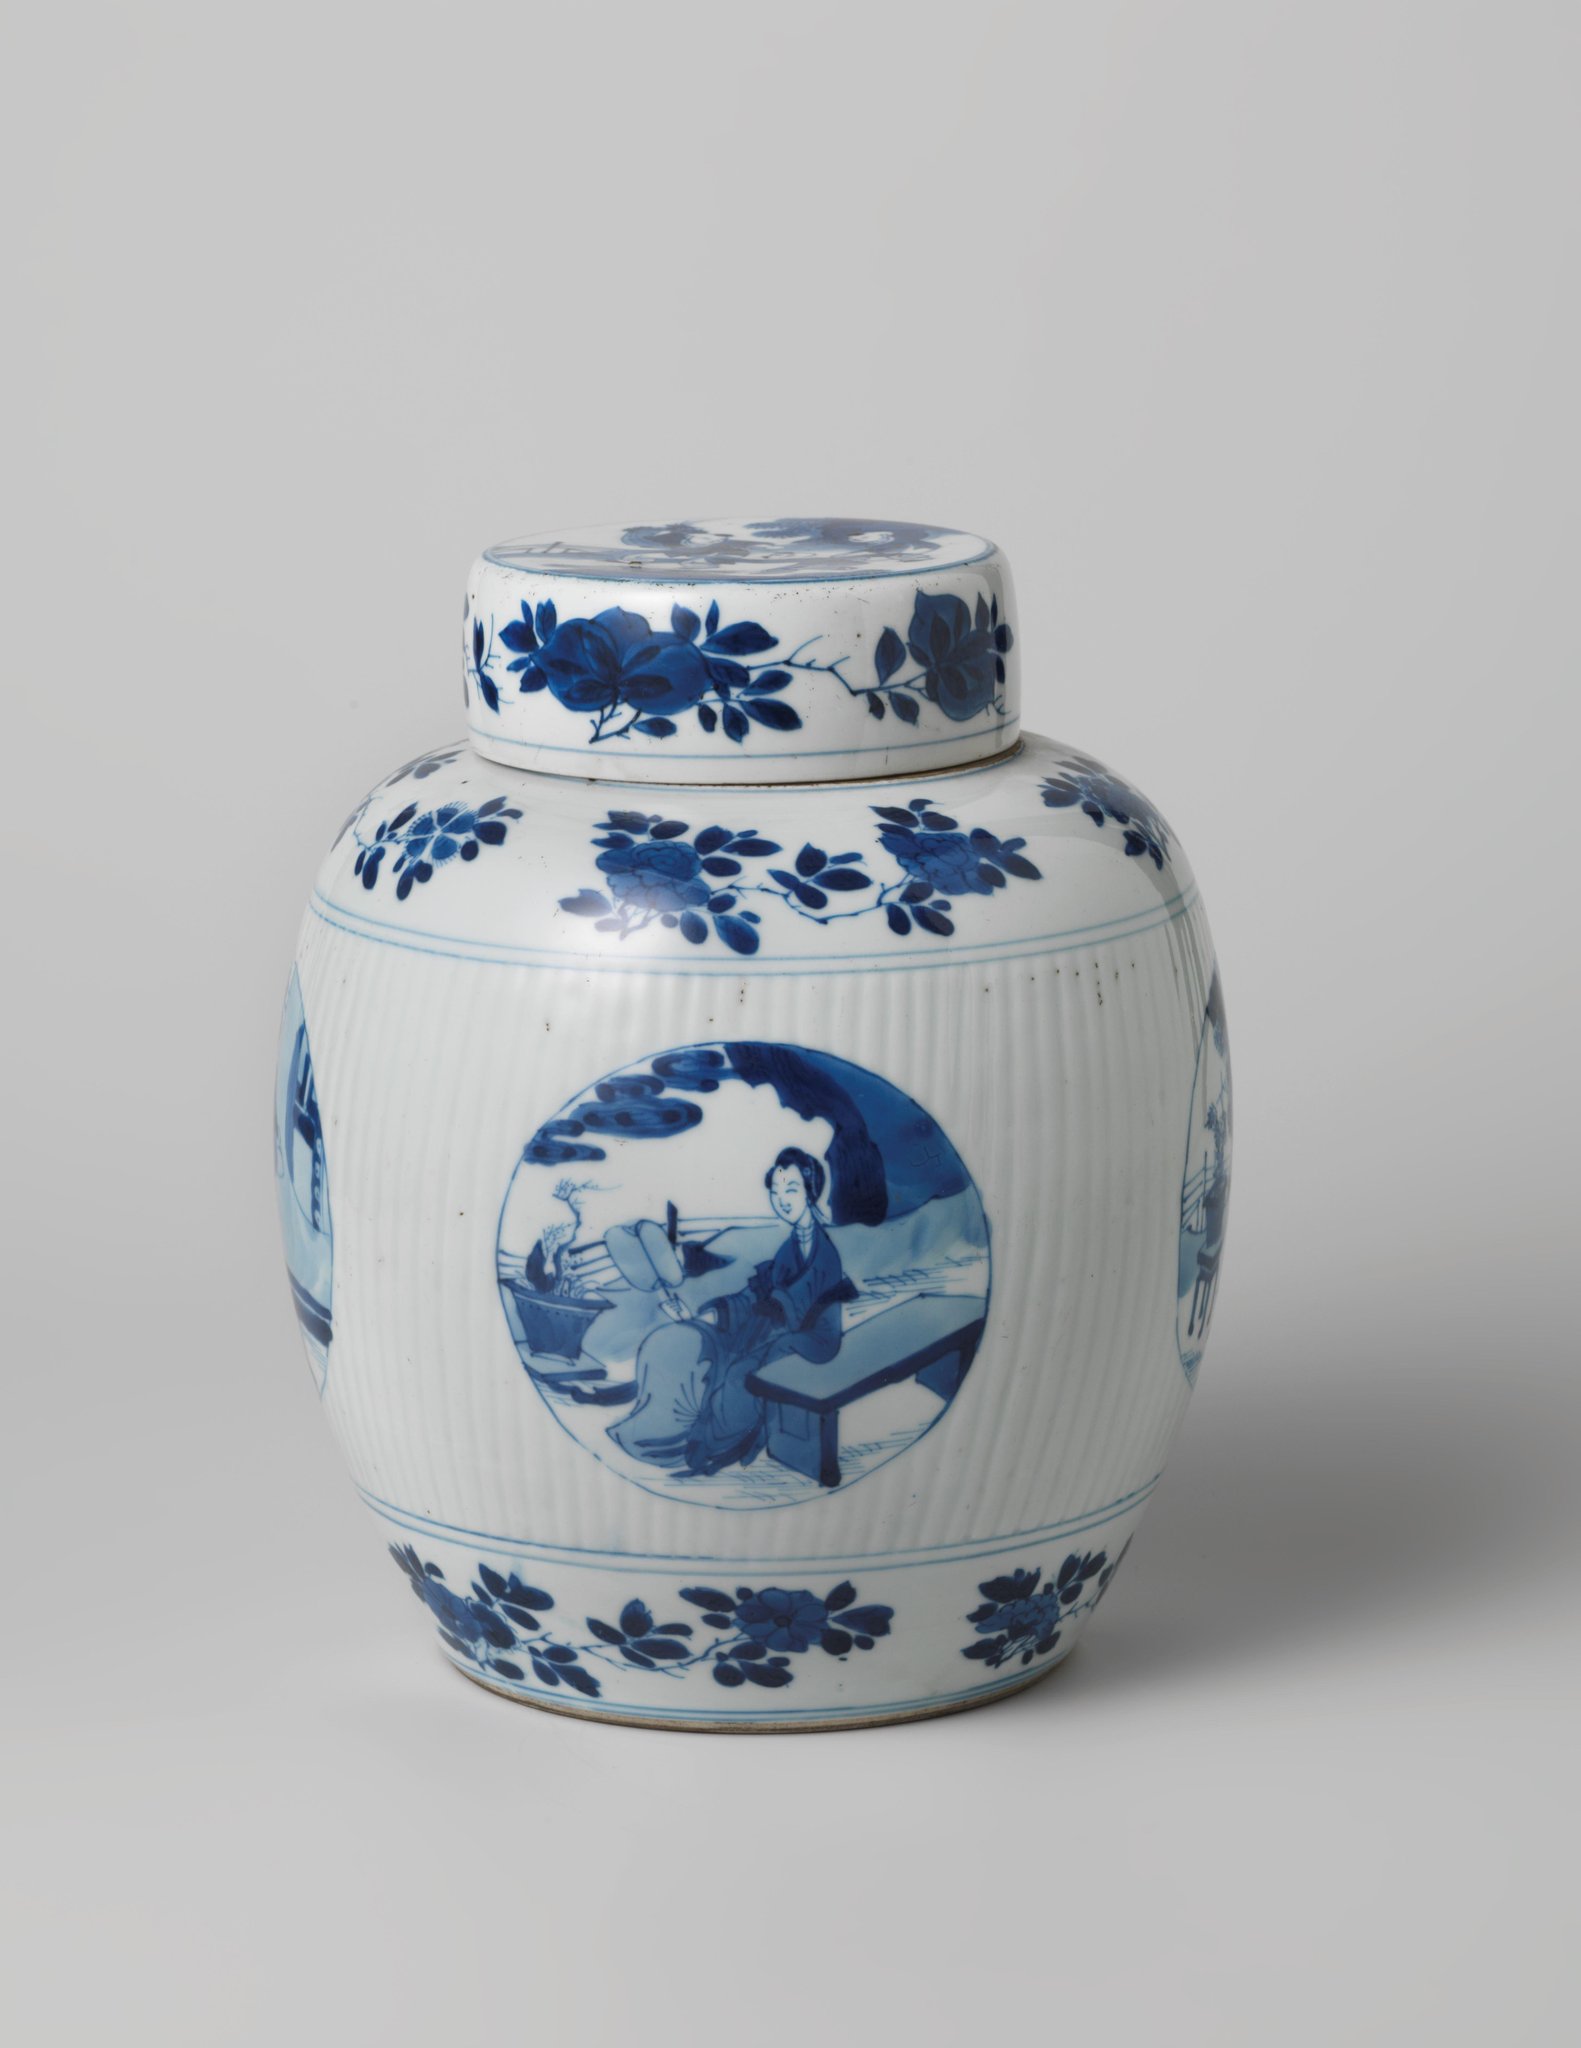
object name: covered jar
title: Ovoid covered jar with fluted sides and figures in medallions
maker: Anonymous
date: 1700-1724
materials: cobalt, glaze, paint, porcelain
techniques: firing, forming, turning, vitrification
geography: china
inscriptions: mark: ‘大 明 成 化 年 製 dà míng Chéng huà nián zhì’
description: Plat deksel van eivormige dekselpot van porselein, beschilderd in onderglazuur blauw. Op de rand van de deksel met fruittakken (perzik), de bovenzijde met drie spelende jongens (zotjes) in een omheinde tuin. Blauw-wit.